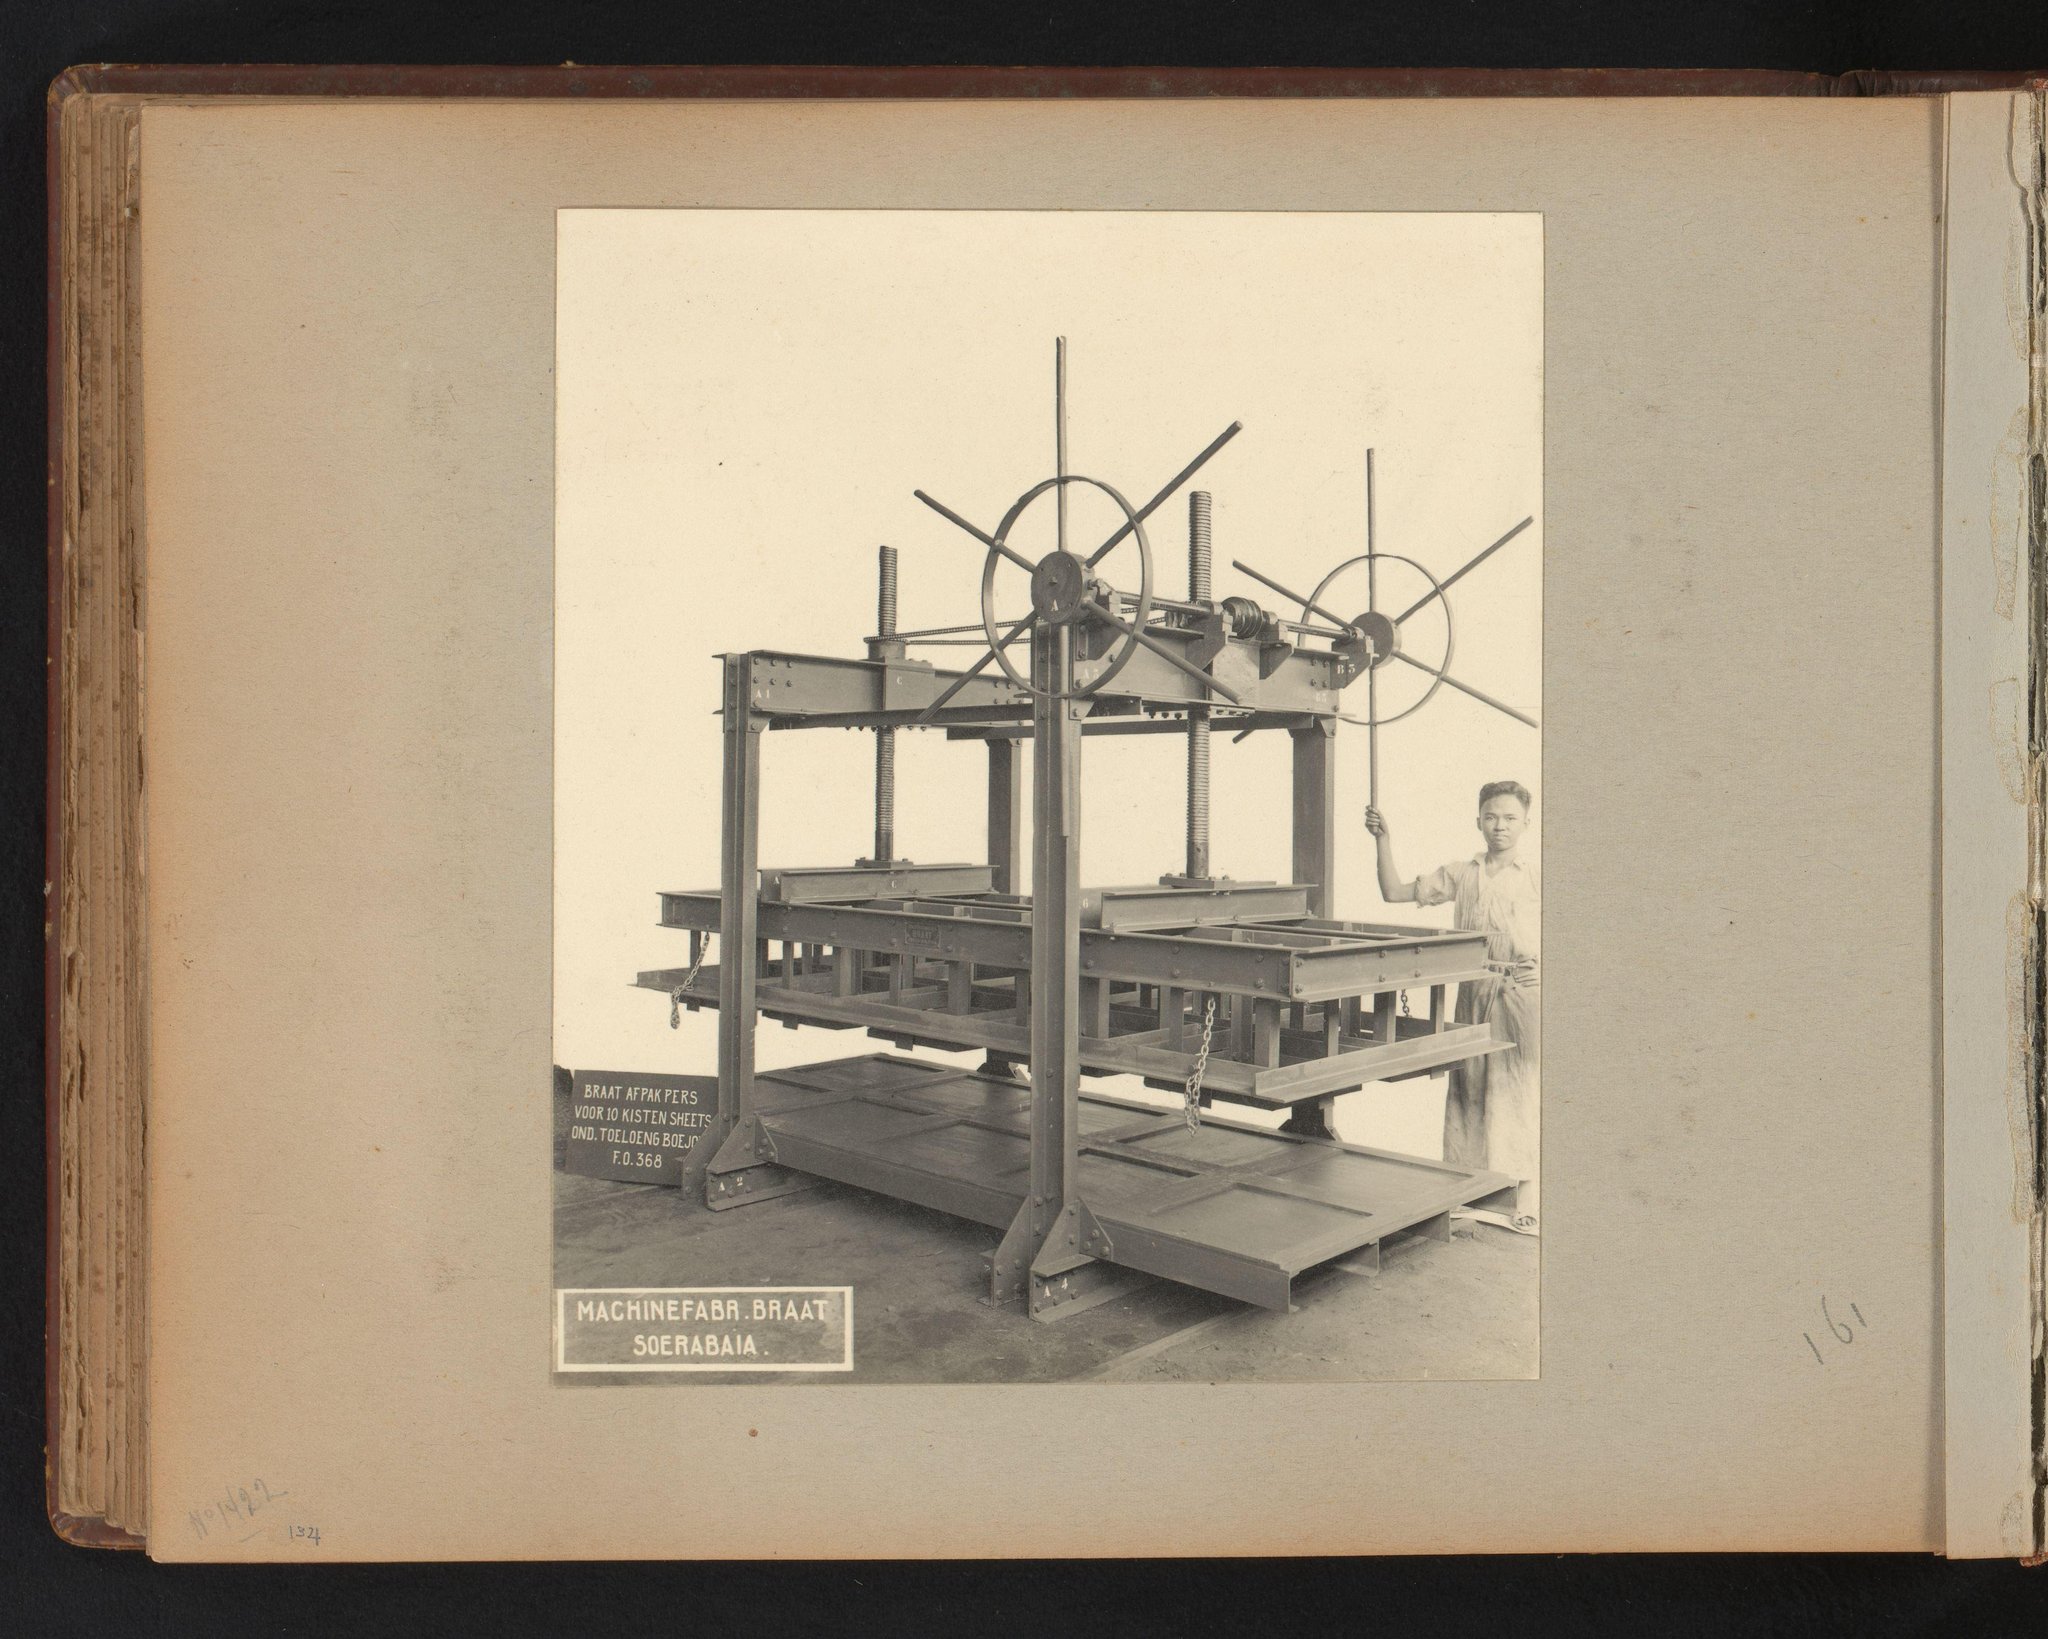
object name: photograph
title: Braat afpak pers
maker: Anonymous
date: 1931-1937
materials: cardboard, photographic support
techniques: gelatin silver print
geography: surabaya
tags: machines; parts of machines; tools and appliances, java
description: Albumblad met een foto van een afpakpers voor kisten sheets (waarschijnlijk voor een rubberfabriek). Onderdeel van een fotoalbum met foto's van machines en constructies van de N.V. Machinefabriek Braat te Soerabaja, Soekaboemi en Tegal uit de periode 1931-1937.